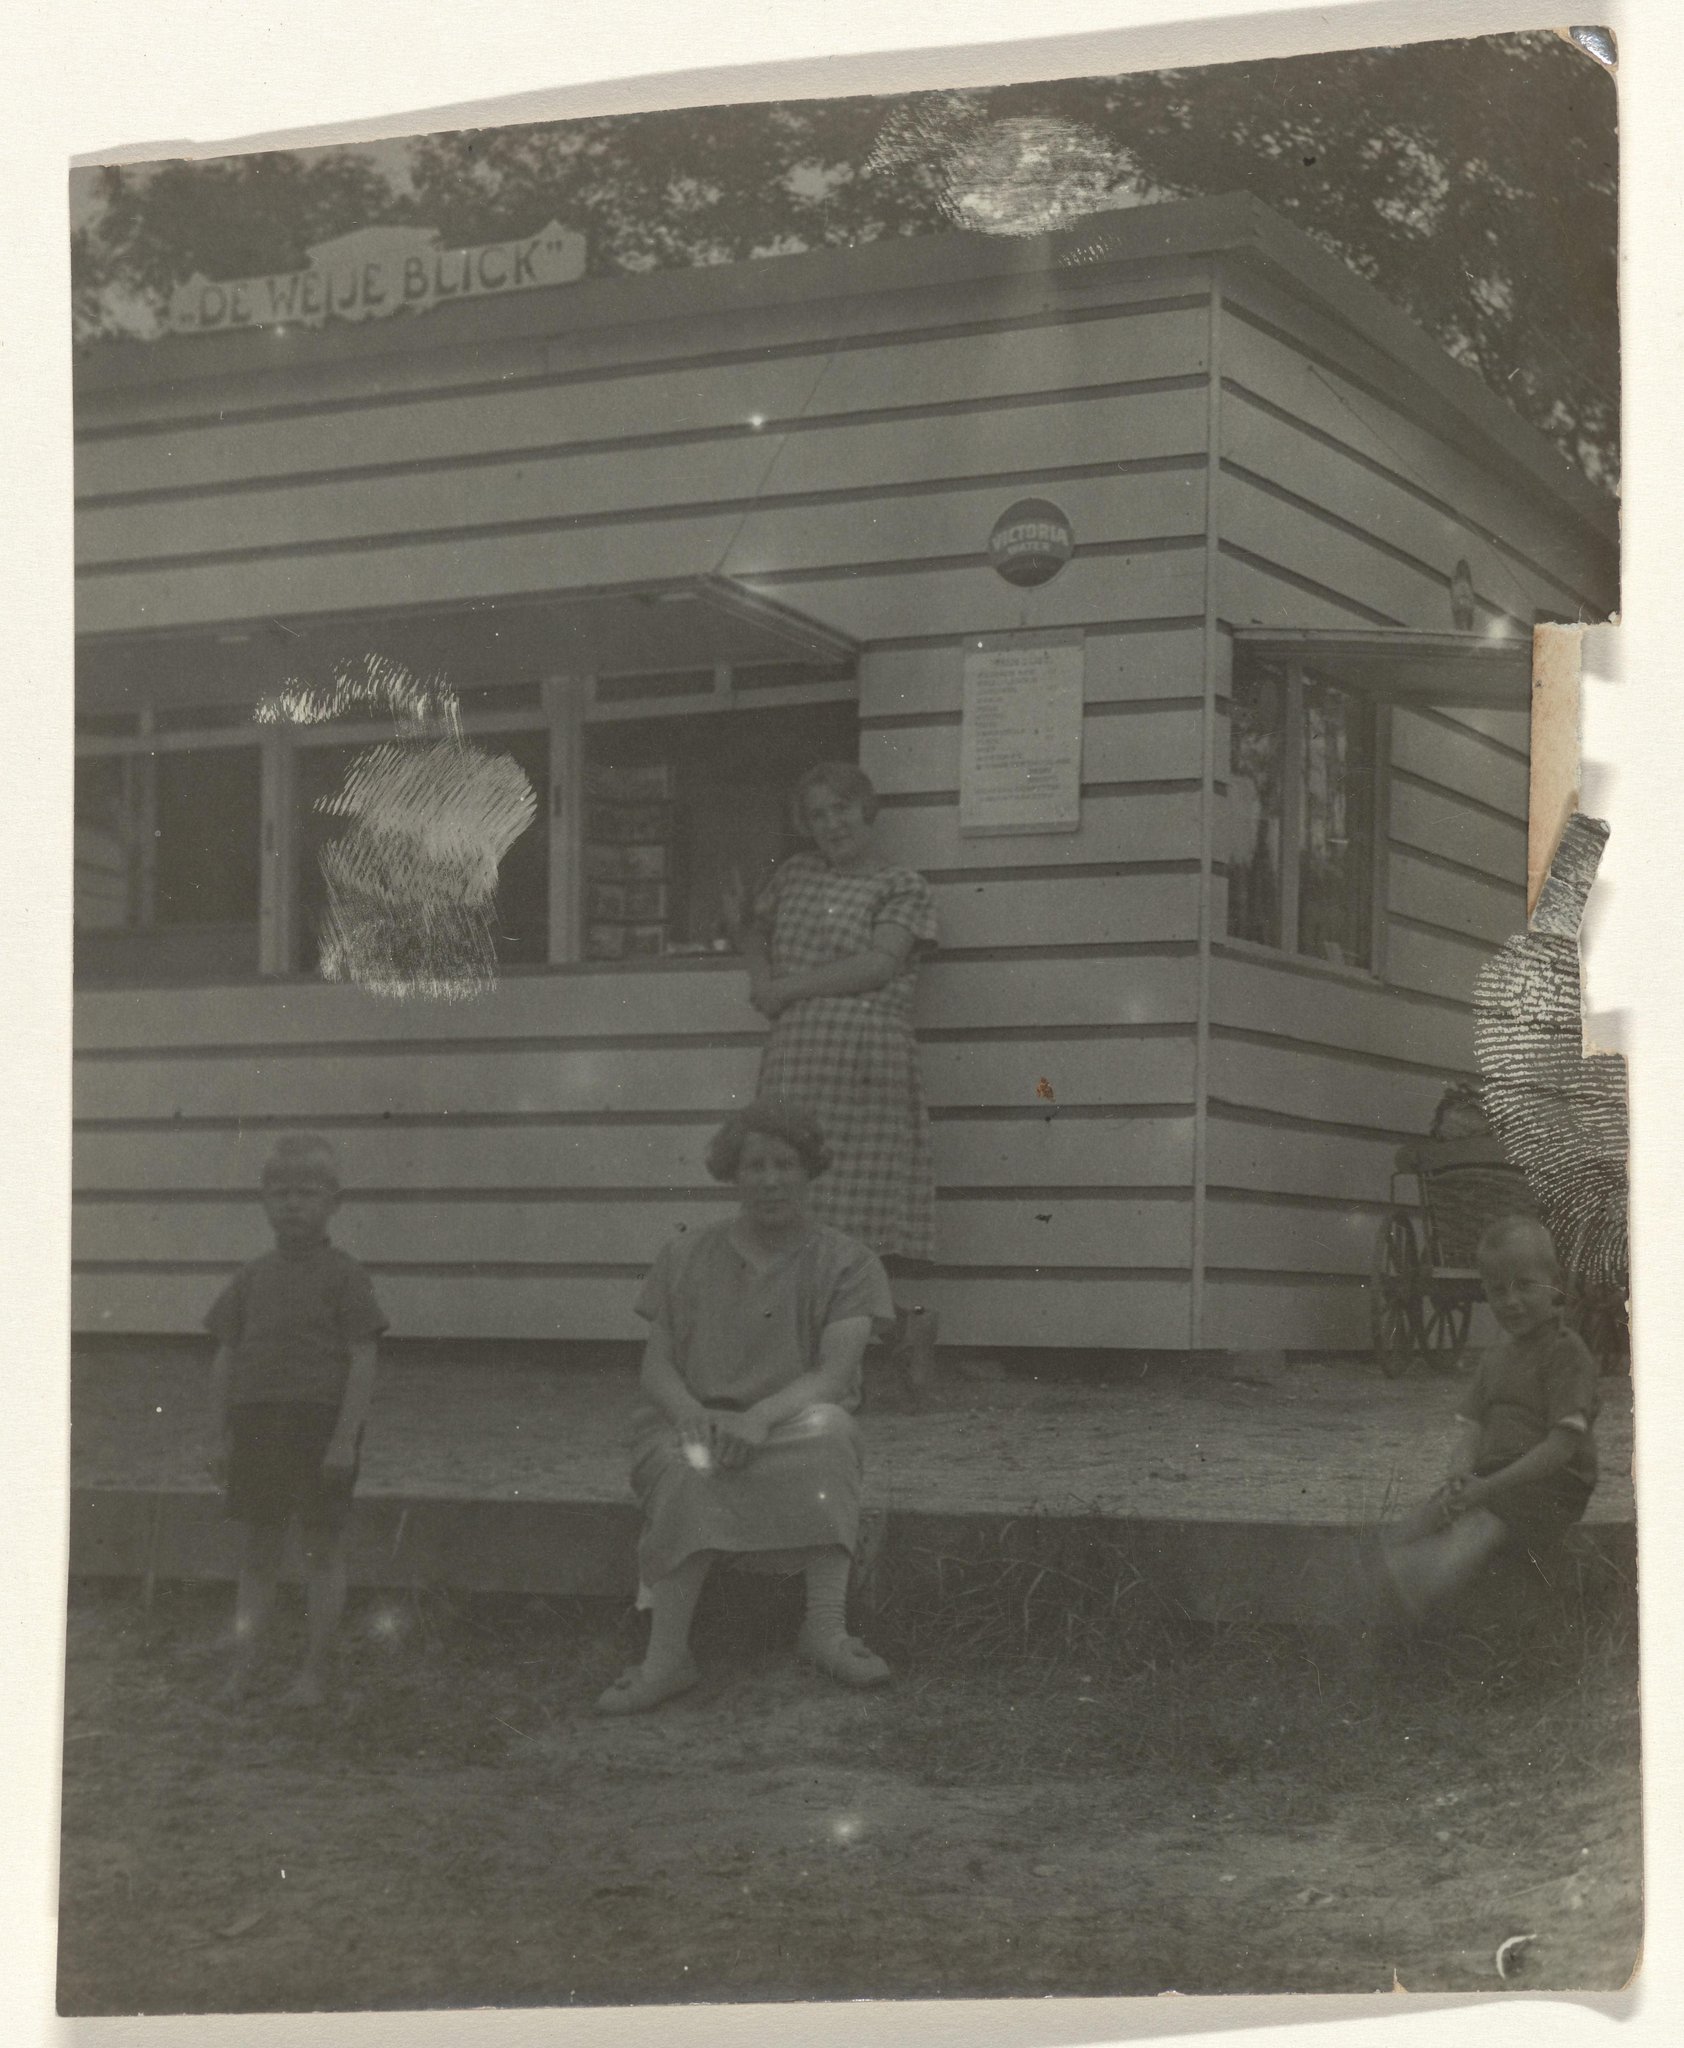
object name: photograph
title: Strandtent De Weije Blick te Valkeveen met op de voorgrond Catharina Maria, Koosje, Daan en Ben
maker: Anonymous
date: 1925-1940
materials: metal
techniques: ferrotyping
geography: valkeveen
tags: beach (as place of recreation)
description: Strandtent De Weije blick te Valkeveen met op de voorgrond een vrouw met drie kinderen.